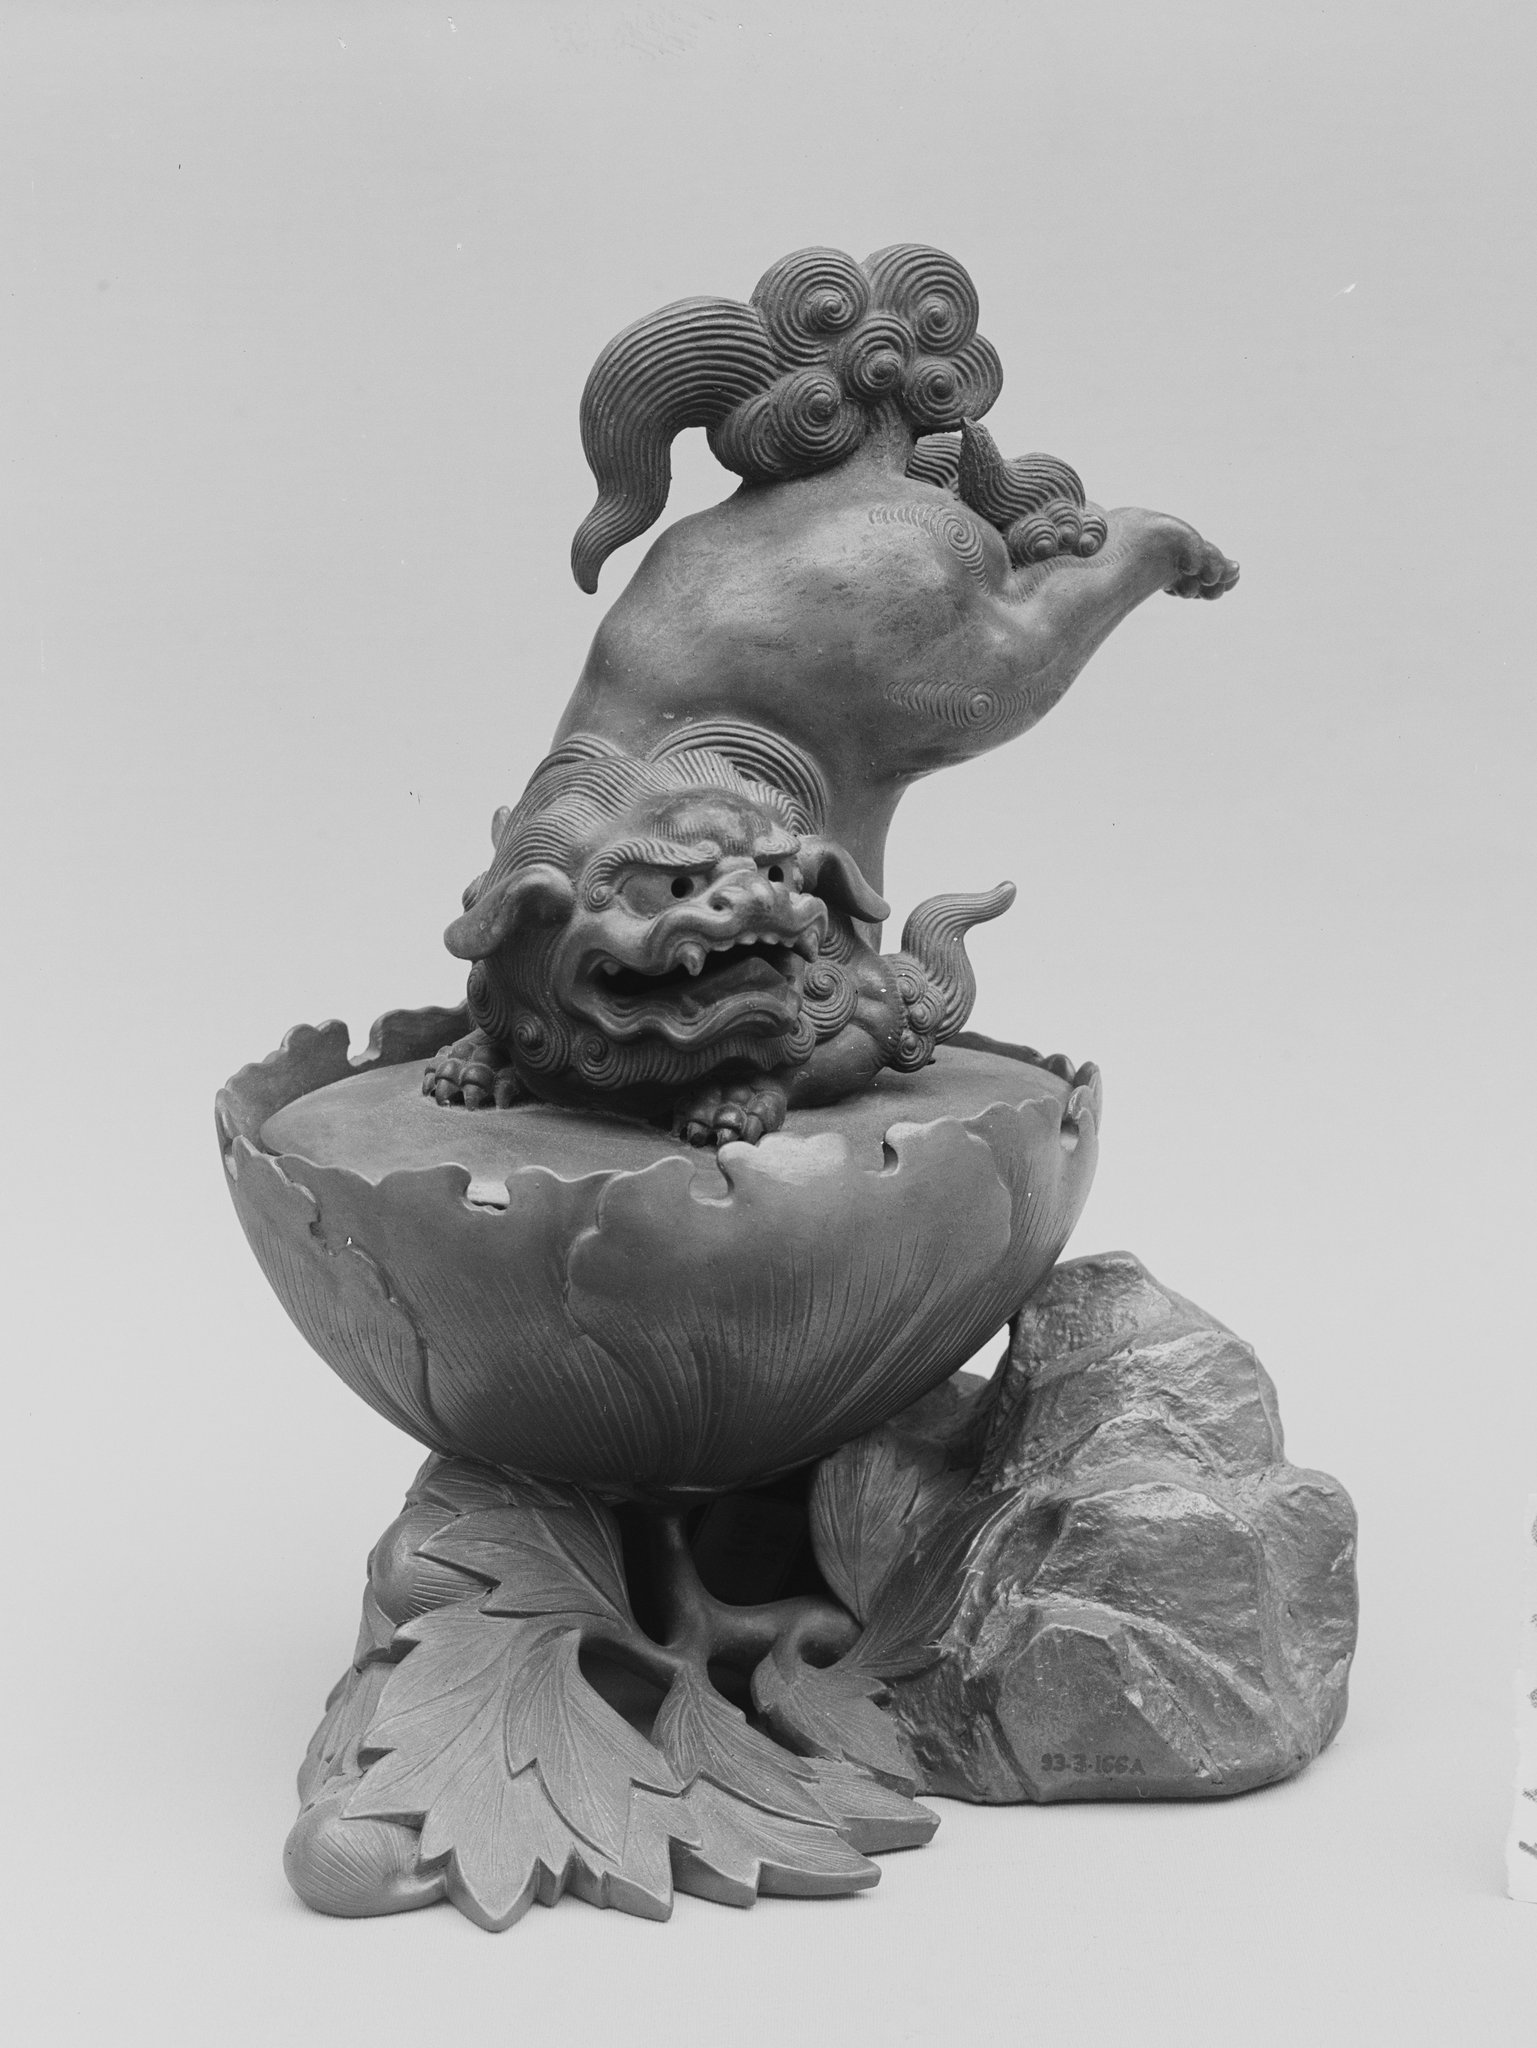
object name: incense burner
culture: japanese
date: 1650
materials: clay, glaze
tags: lions